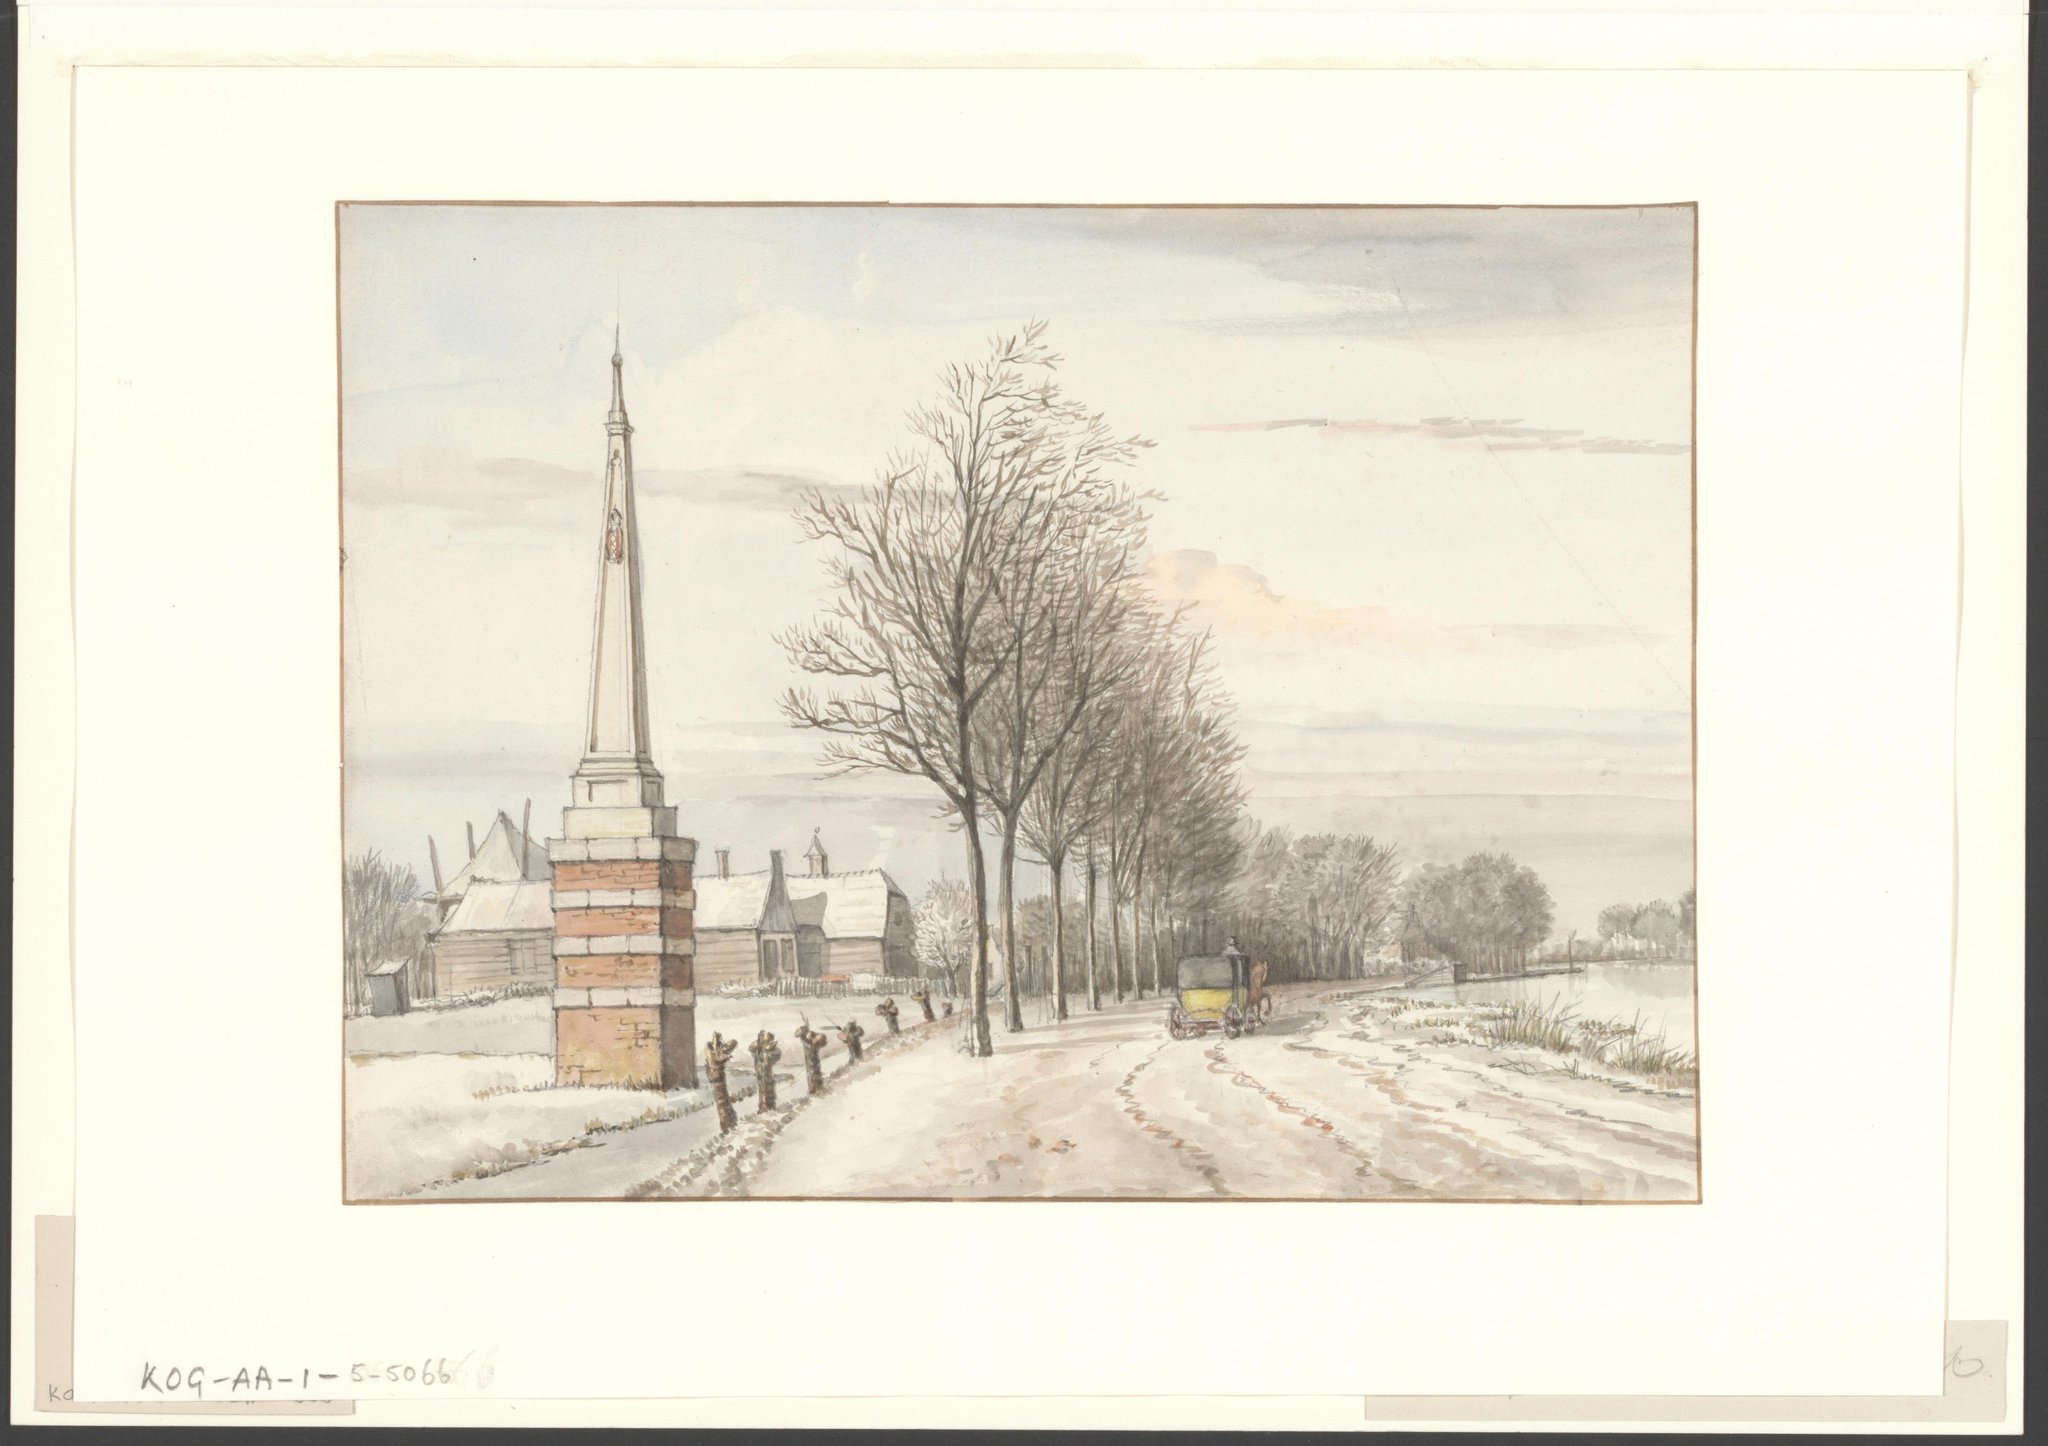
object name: drawing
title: Gezicht op de mijlpaal aan de Amsteldijk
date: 1786-1850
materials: paper, pencil, watercolor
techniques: brush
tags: obelisk, needle, city-view in general; 'veduta', road, path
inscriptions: inscription: ‘Mijlpaal a.d Amsteldijk.’, collector's mark: ‘5’ Lugt 1641b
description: Onderwerpsrubriek binnen de Atlas Amsterdam: Amstel buiten de stad, Amsteldijk.